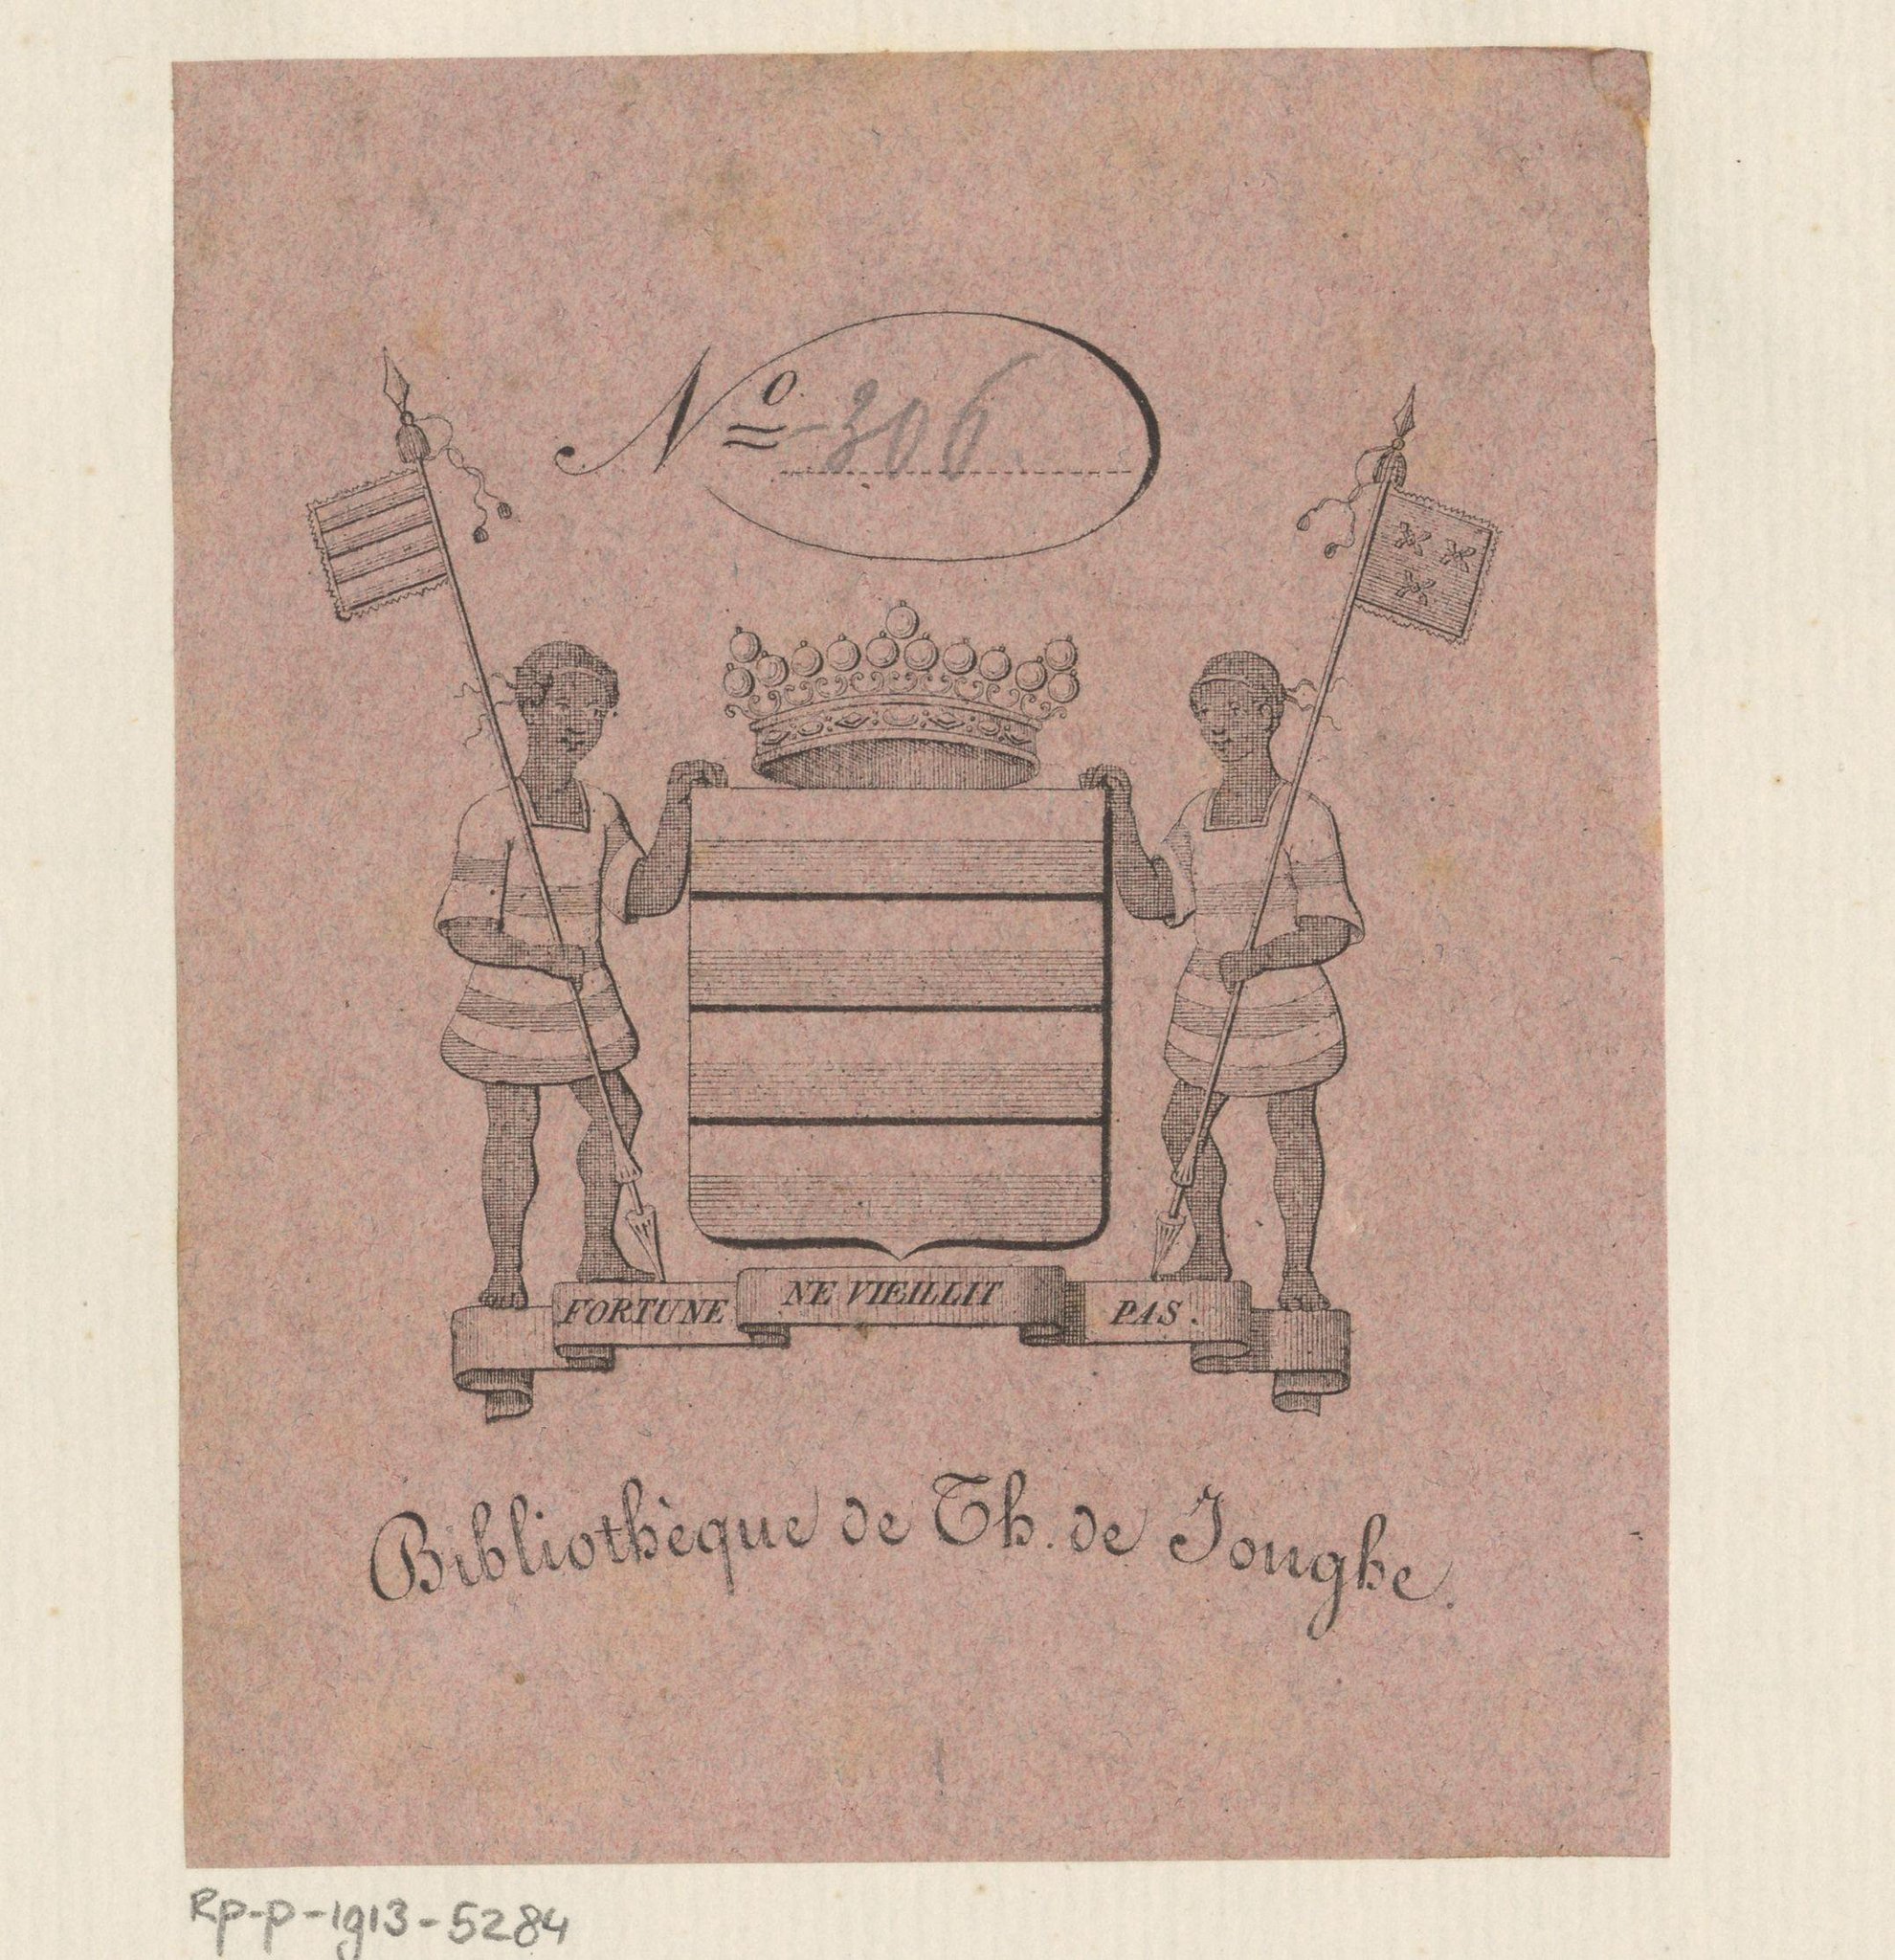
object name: bookplate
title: Ex libris van Bibliothèque de Th. de Jonghe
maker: Anonymous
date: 1800-1899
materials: paper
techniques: etching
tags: armorial bearing, heraldry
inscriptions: collector's mark: Lugt 2760, number: ‘306’, collector's mark: Lugt 2233